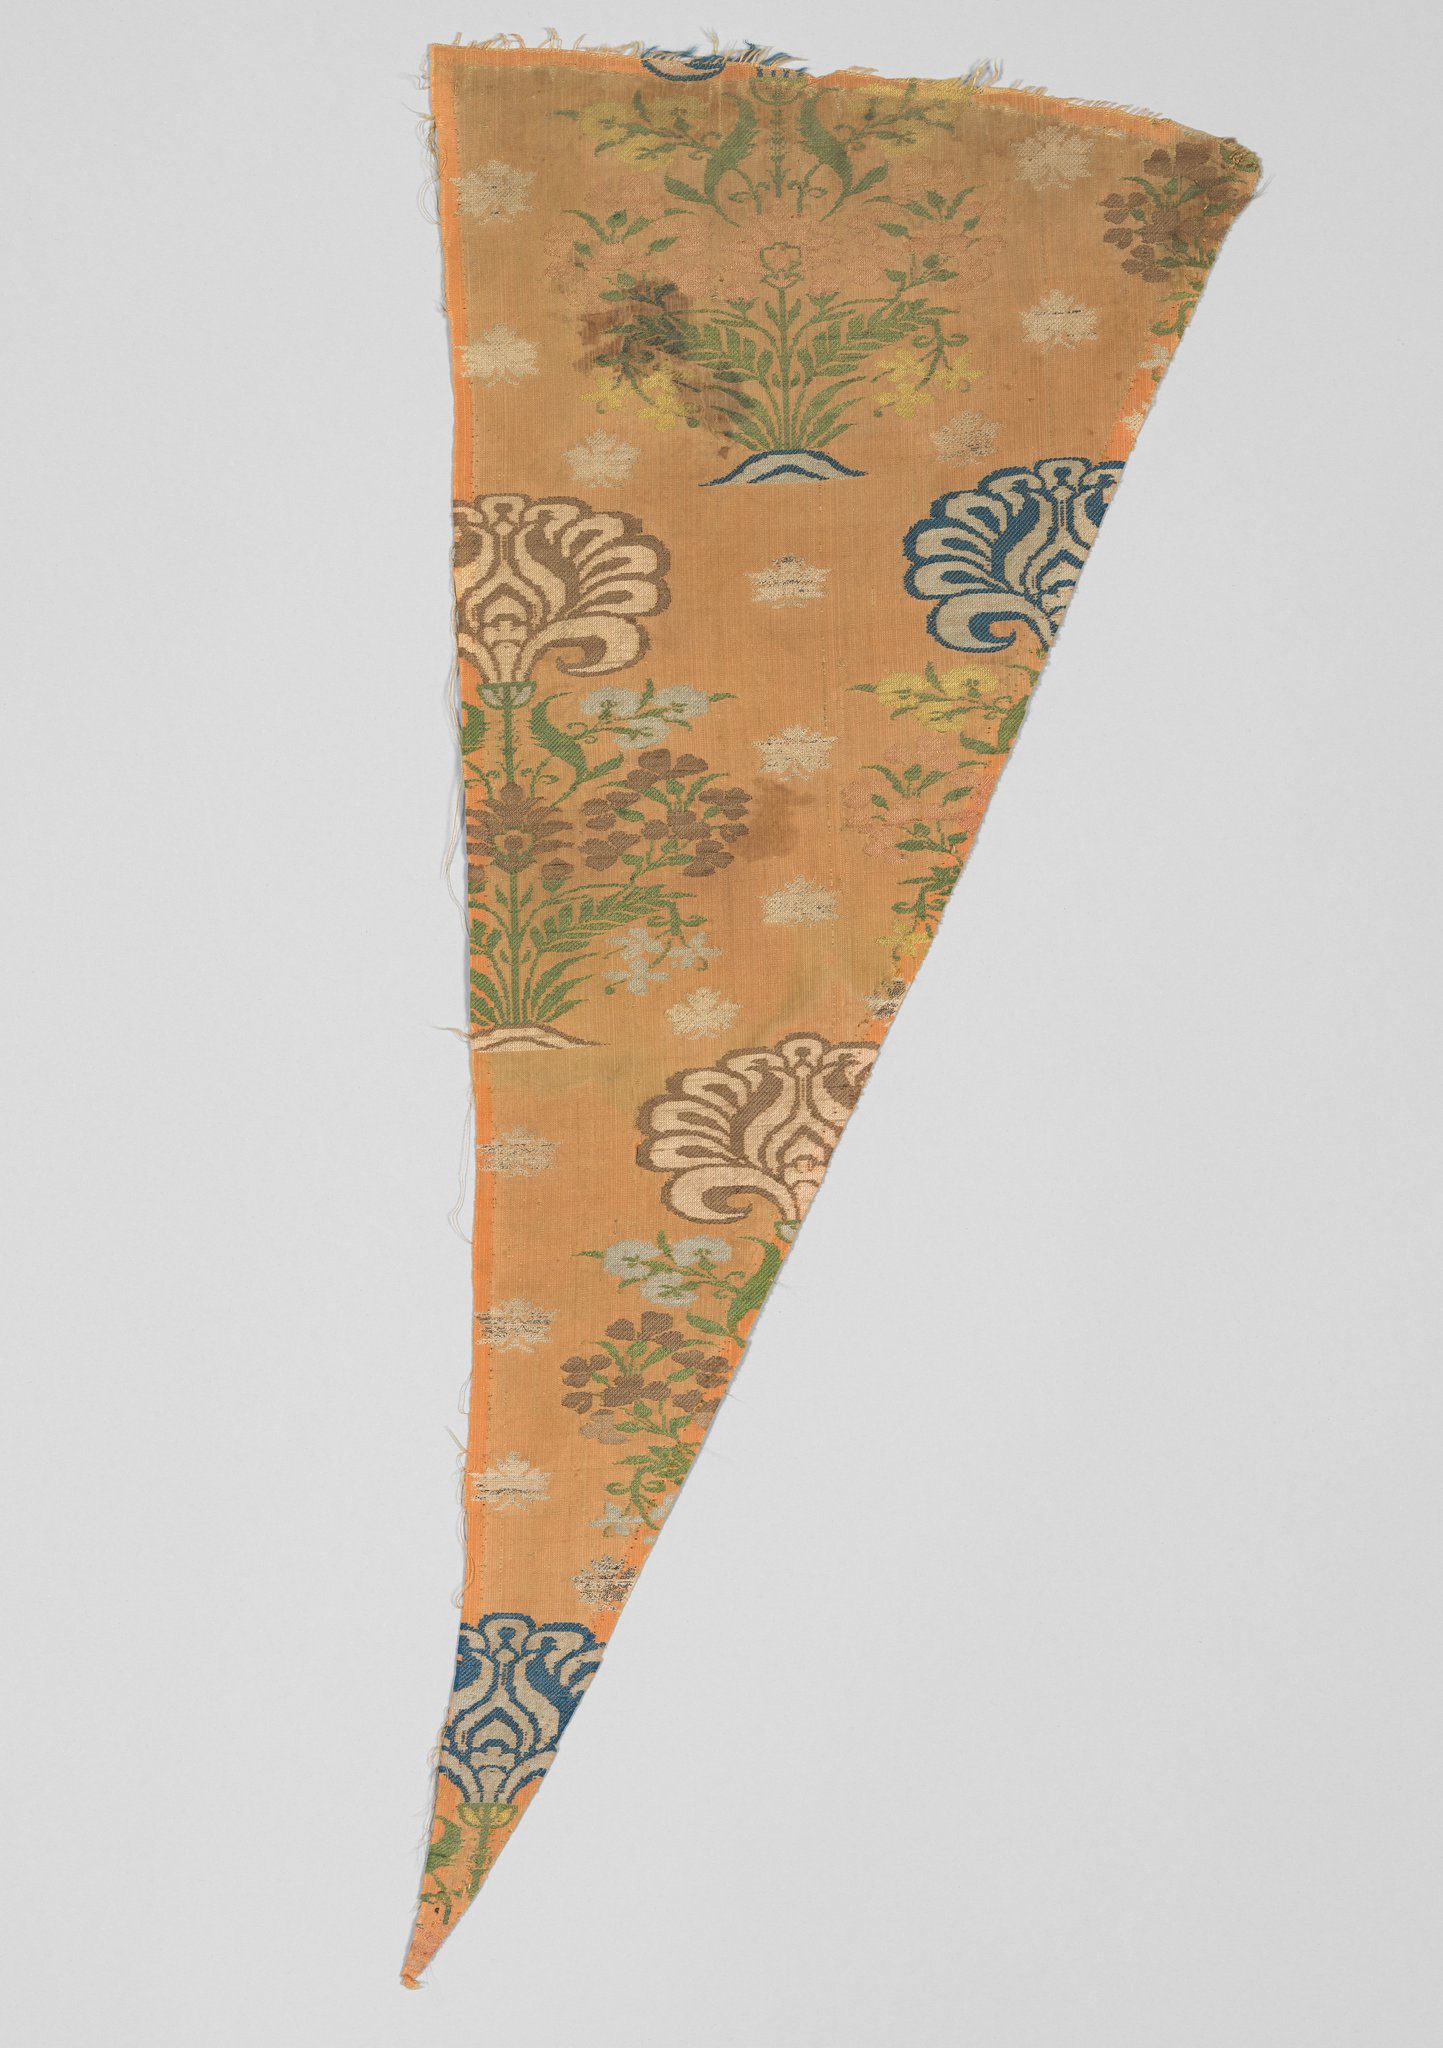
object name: textile fragment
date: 1601-1700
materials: metal thread, silk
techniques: brocade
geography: europe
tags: flowers